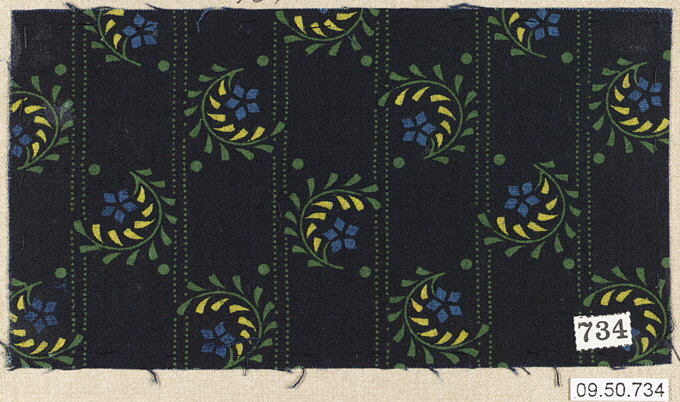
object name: piece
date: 1801-1900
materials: cotton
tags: flowers,leaves